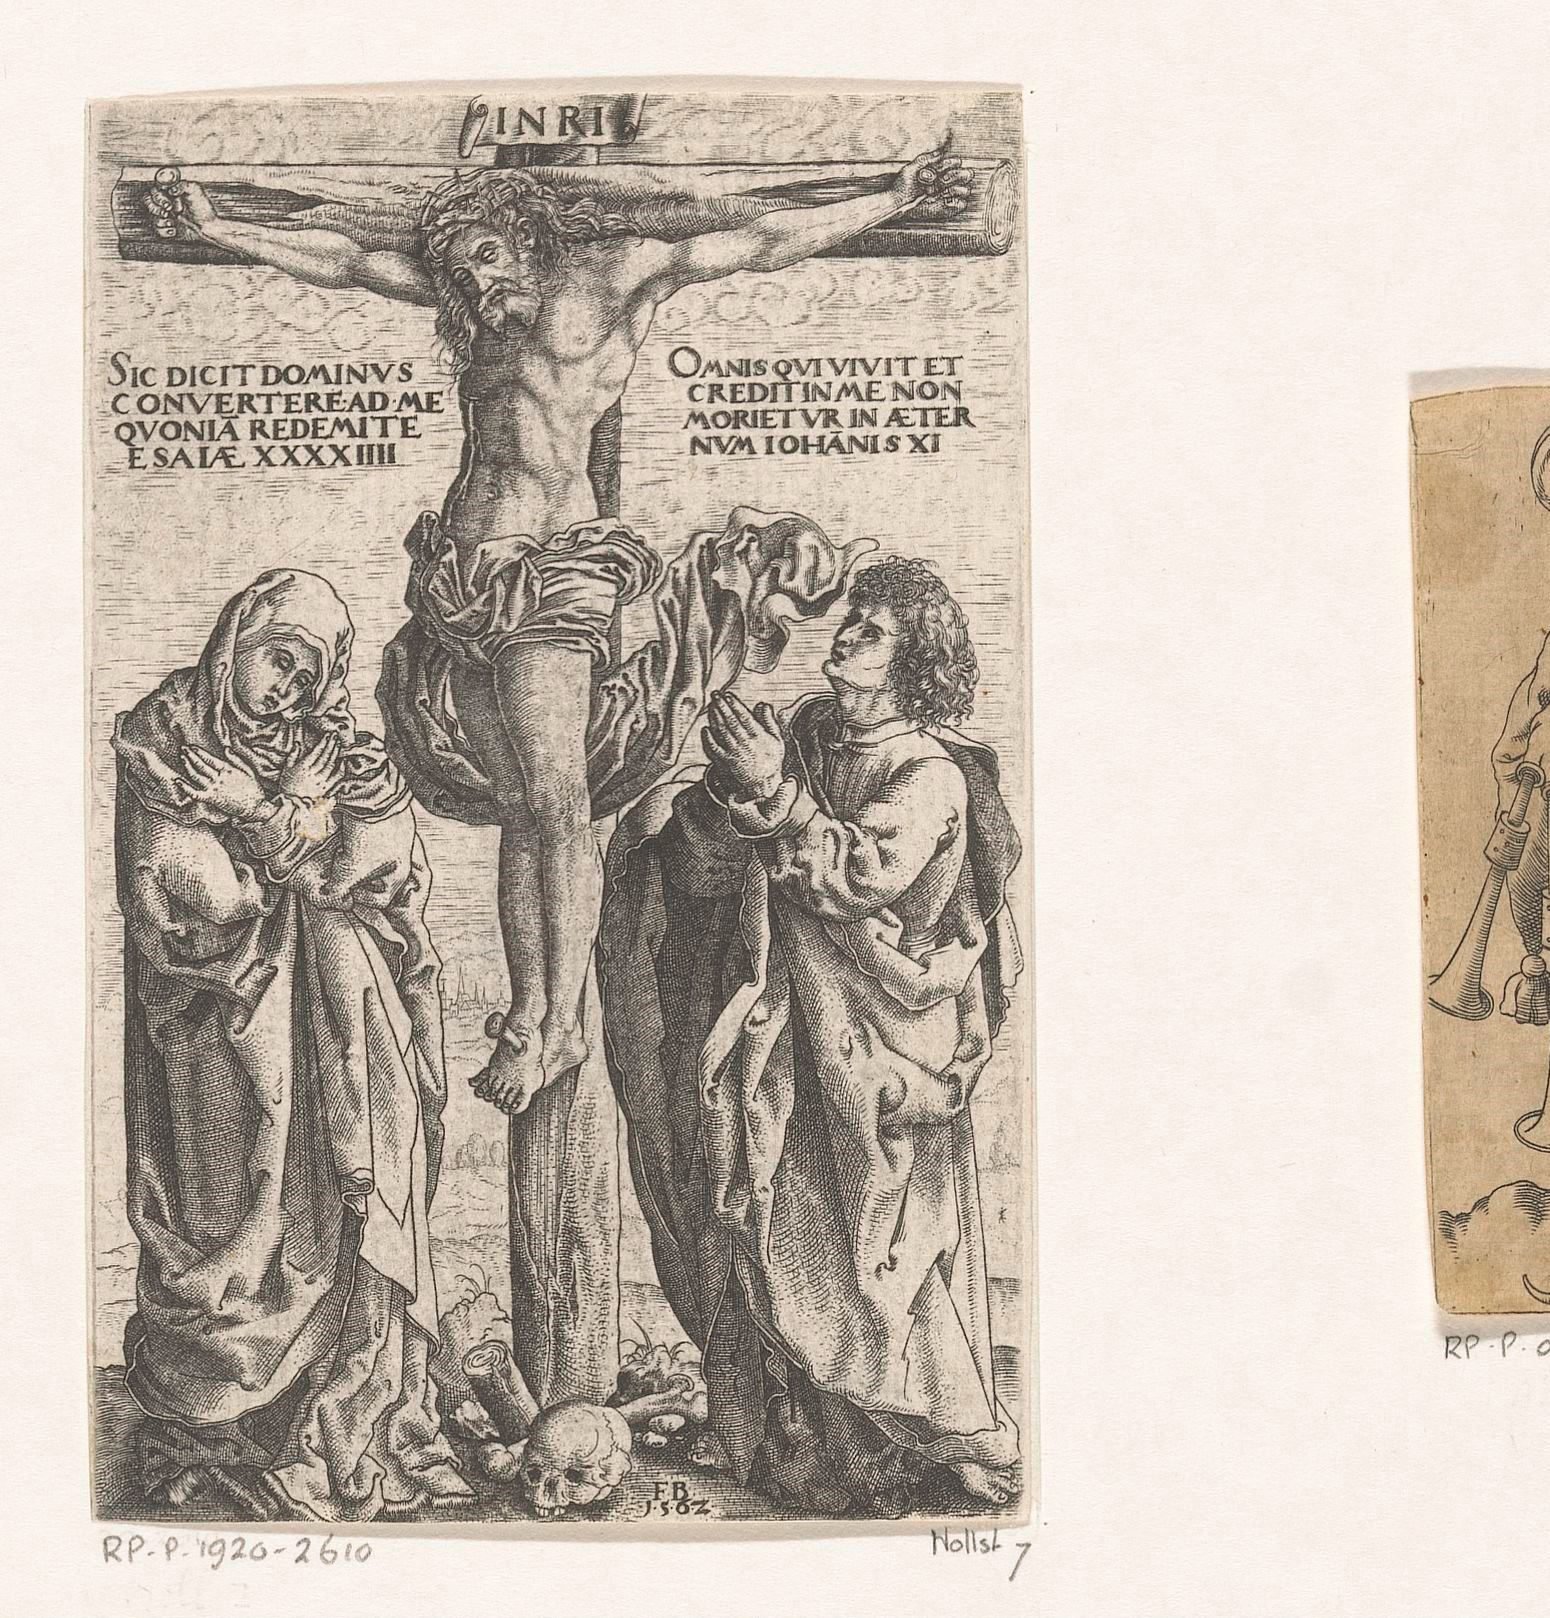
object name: print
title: Christus aan het kruis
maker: franz isaac brun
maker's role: print maker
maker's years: 1535-1620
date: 1562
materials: paper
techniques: engraving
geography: germany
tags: crucified christ with mary and john on either side of the cross; holy rood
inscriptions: collector's mark: Lugt 654, collector's mark: Lugt 2233